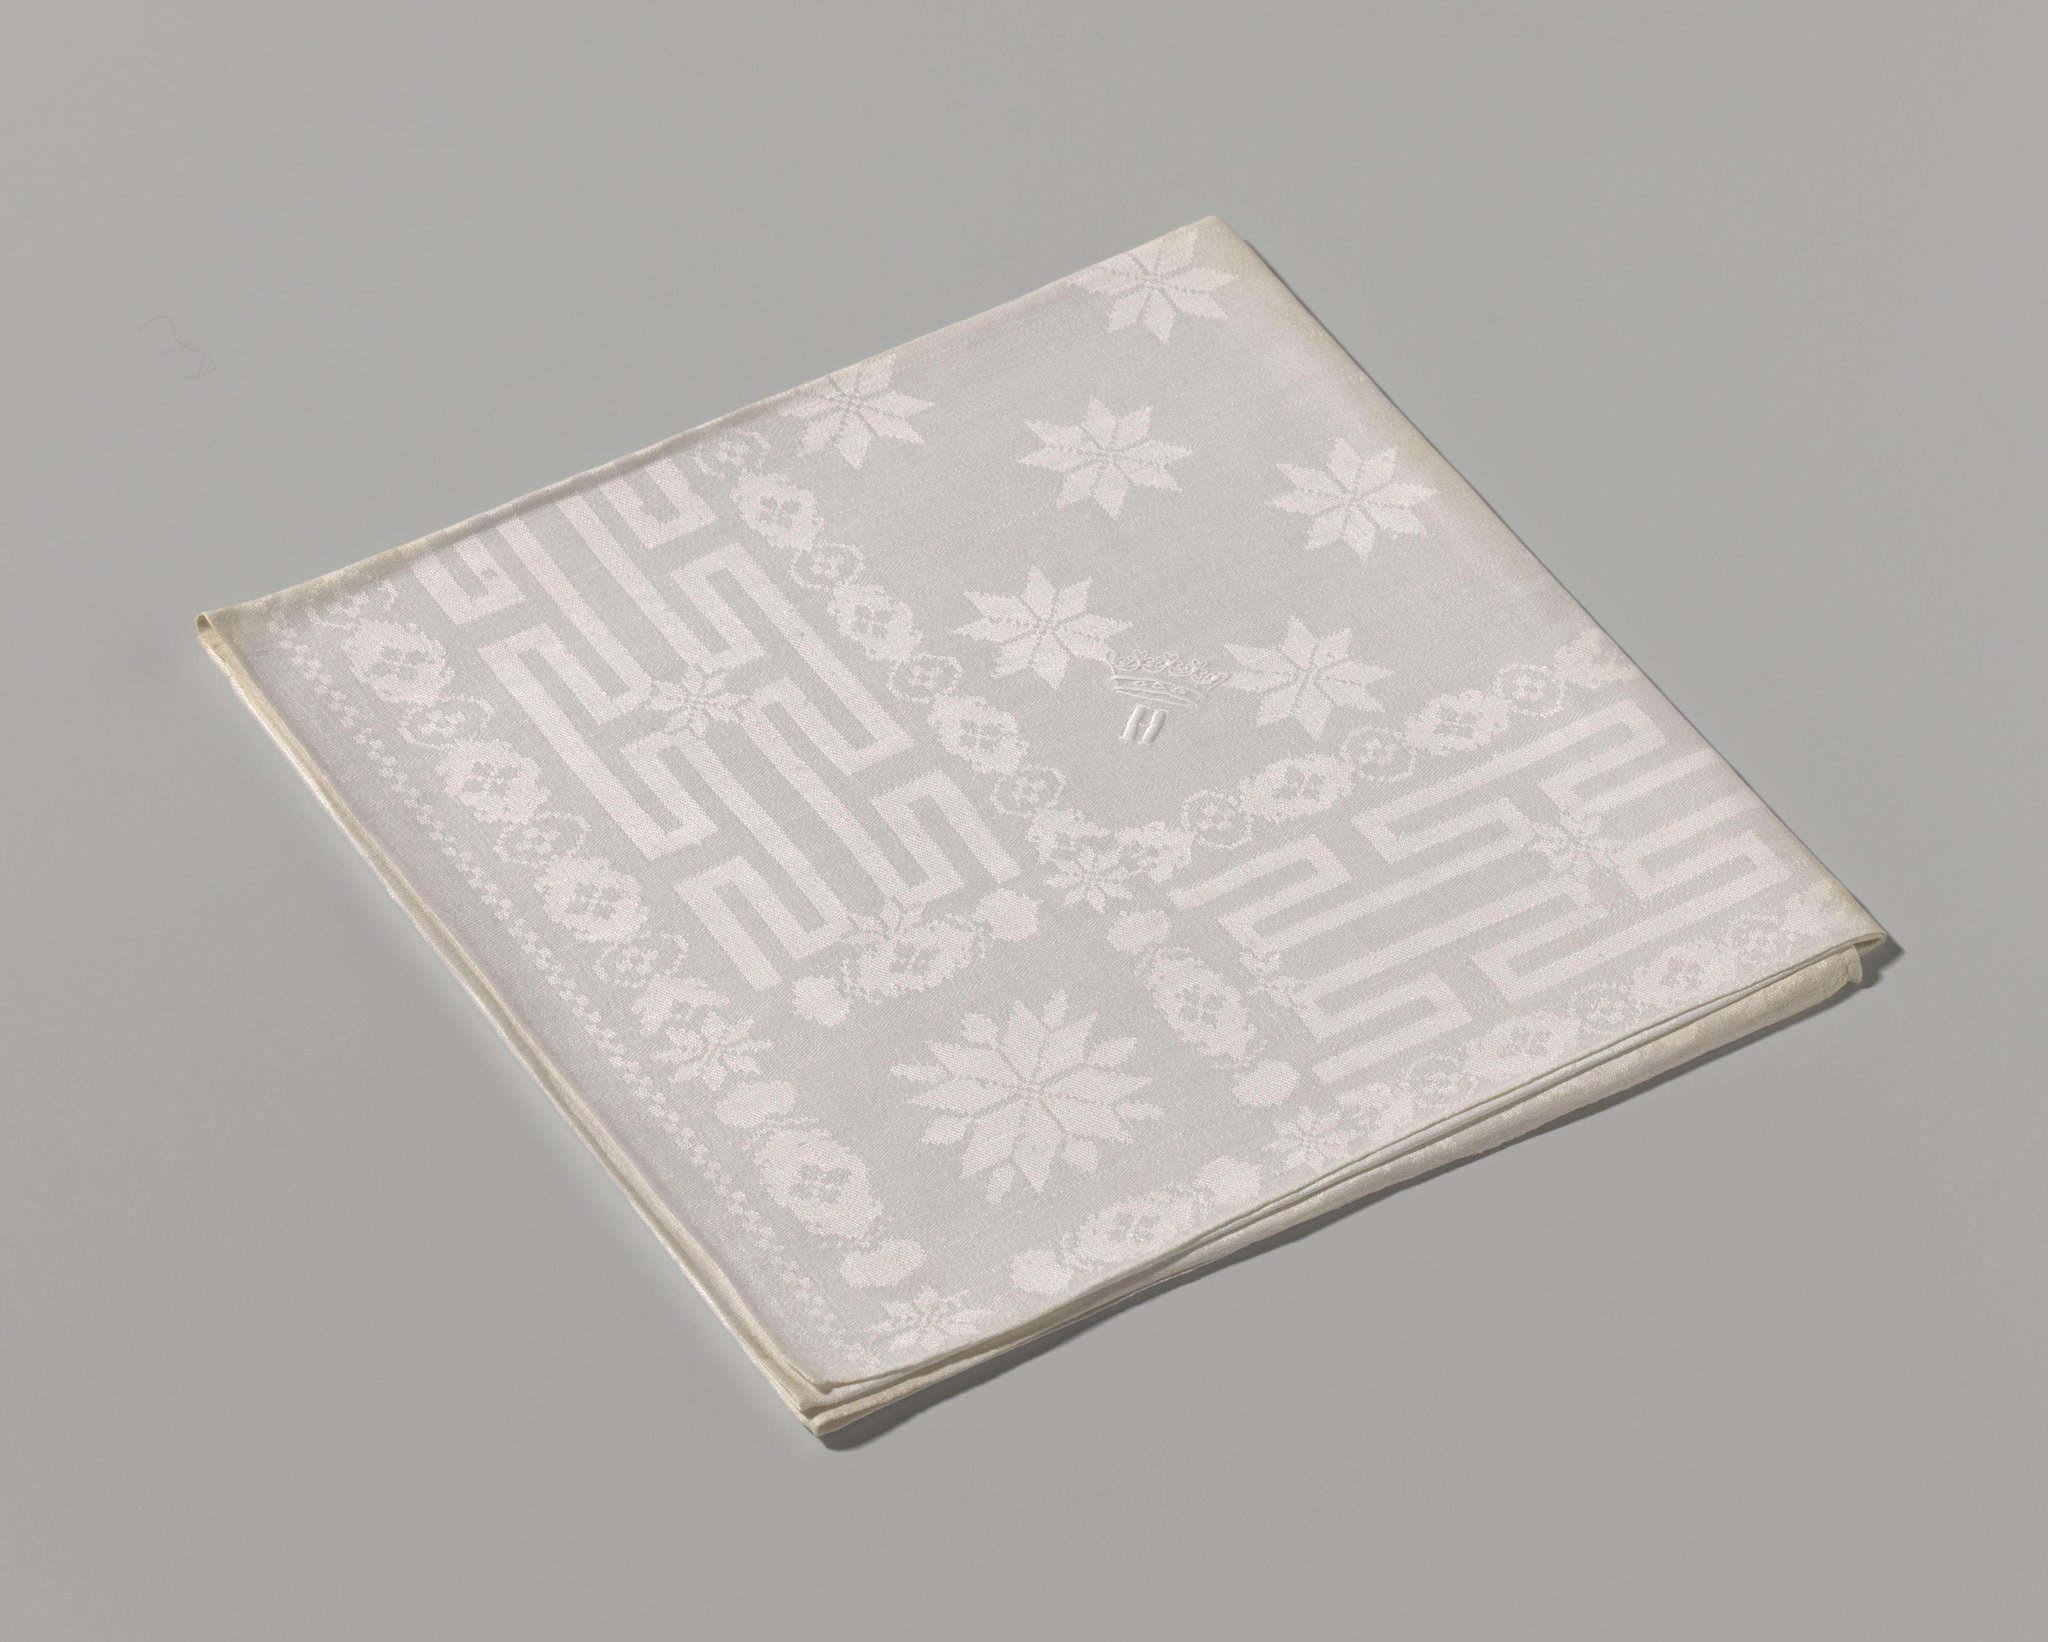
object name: napkin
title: Servet van wit linnendamast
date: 1859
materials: linen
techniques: damask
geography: borne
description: Wit linnen damasten servet met "kleine ster", merk kroon H.